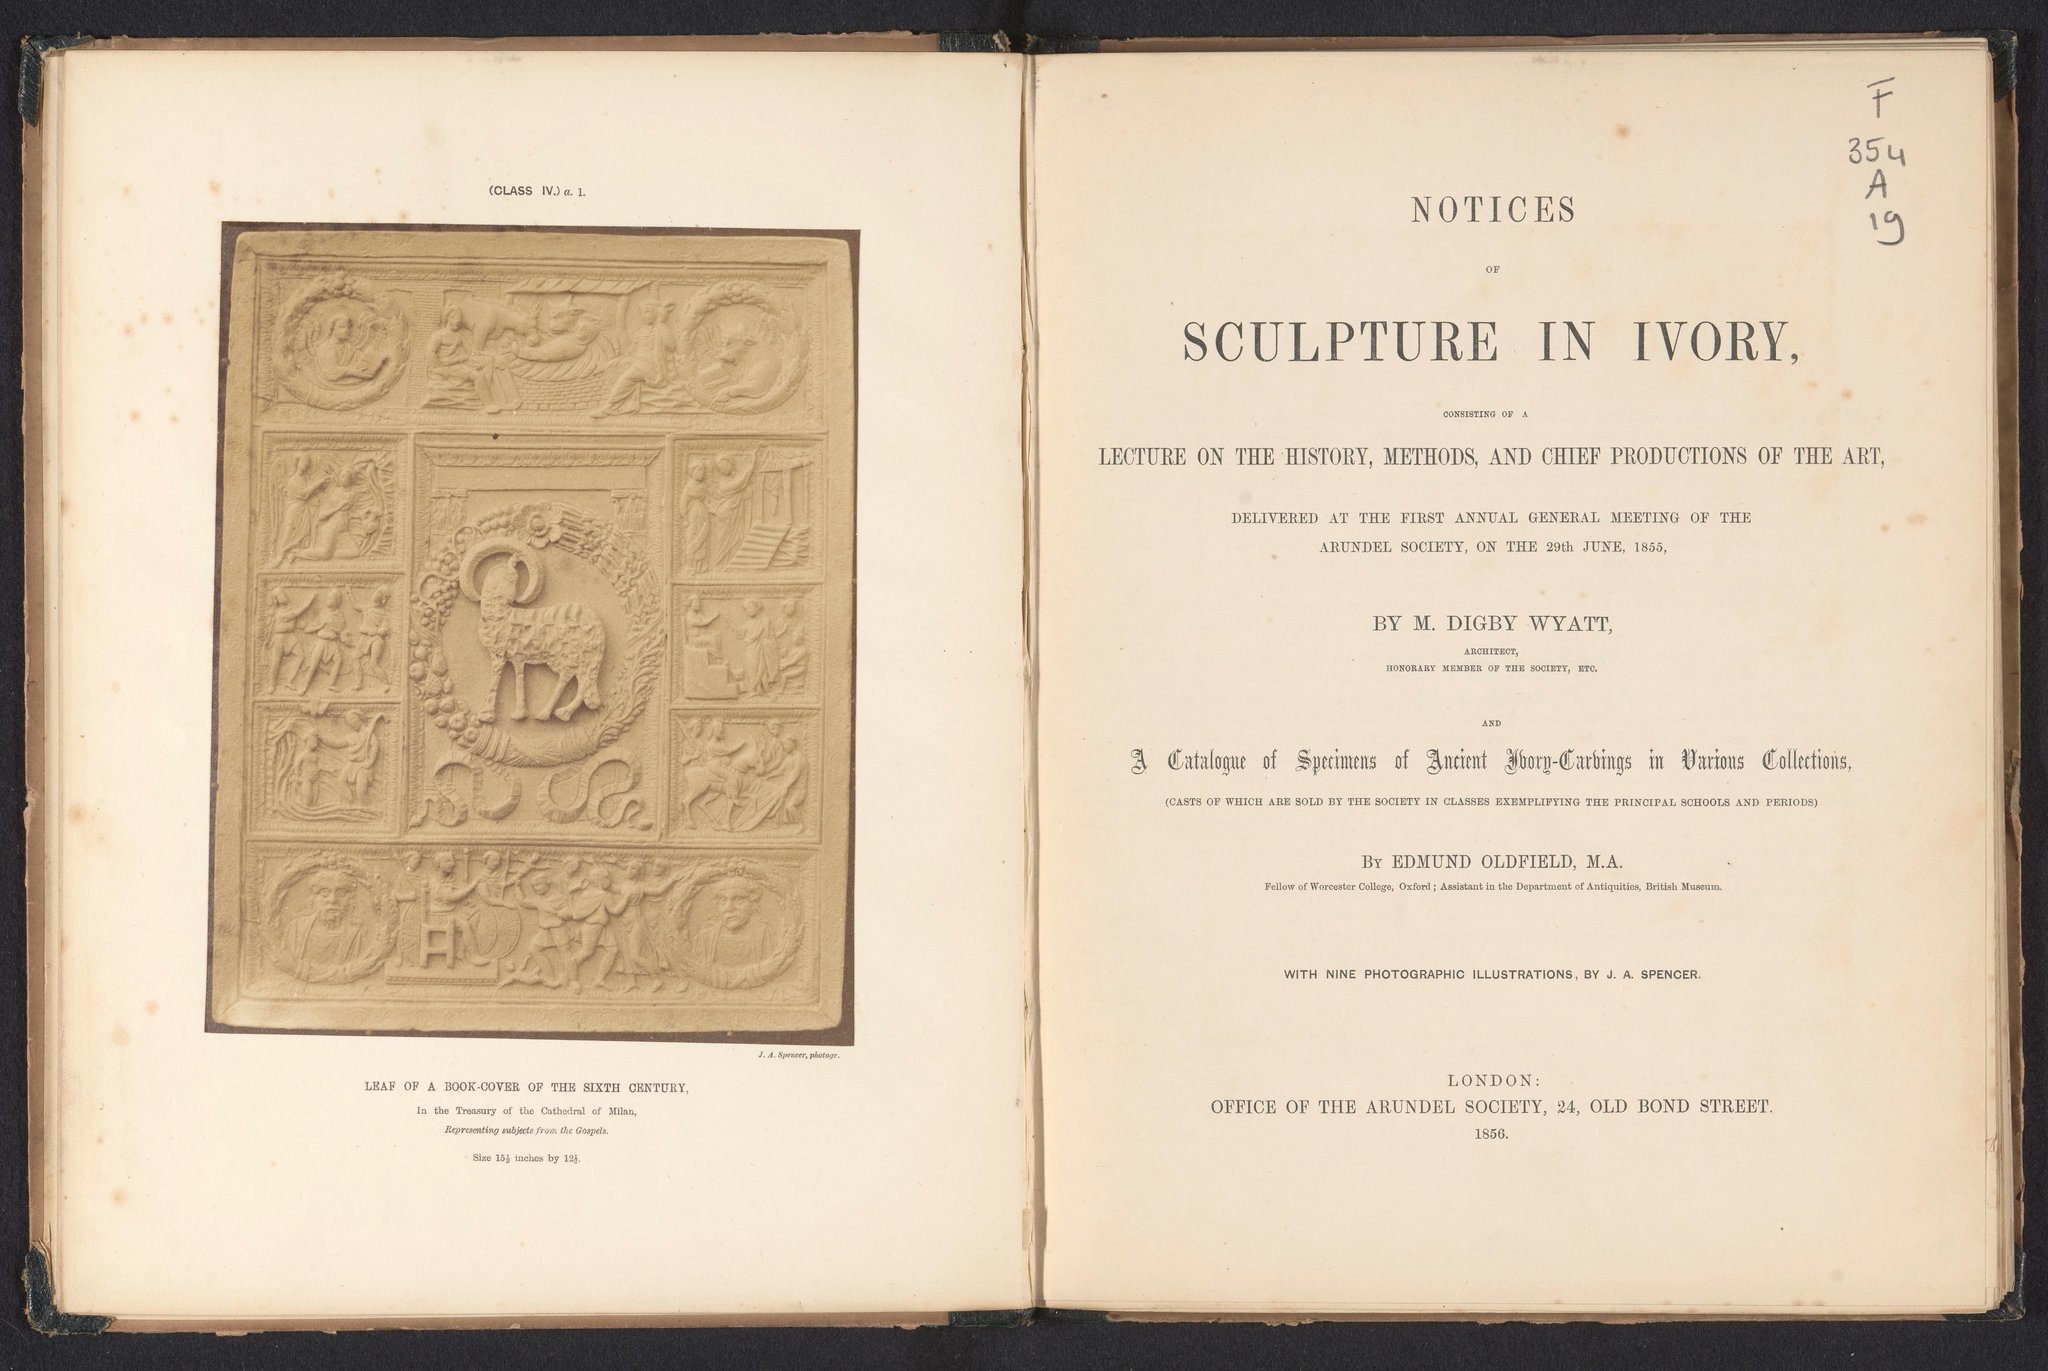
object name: book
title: Notices of sculpture in ivory, consisting of a lecture on the history, methods, and chief productions of the art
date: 1856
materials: cardboard, leather, paper, photographic support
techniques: albumen print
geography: london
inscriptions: inscription: ‘Charles P. Neuter [...] from [...]’